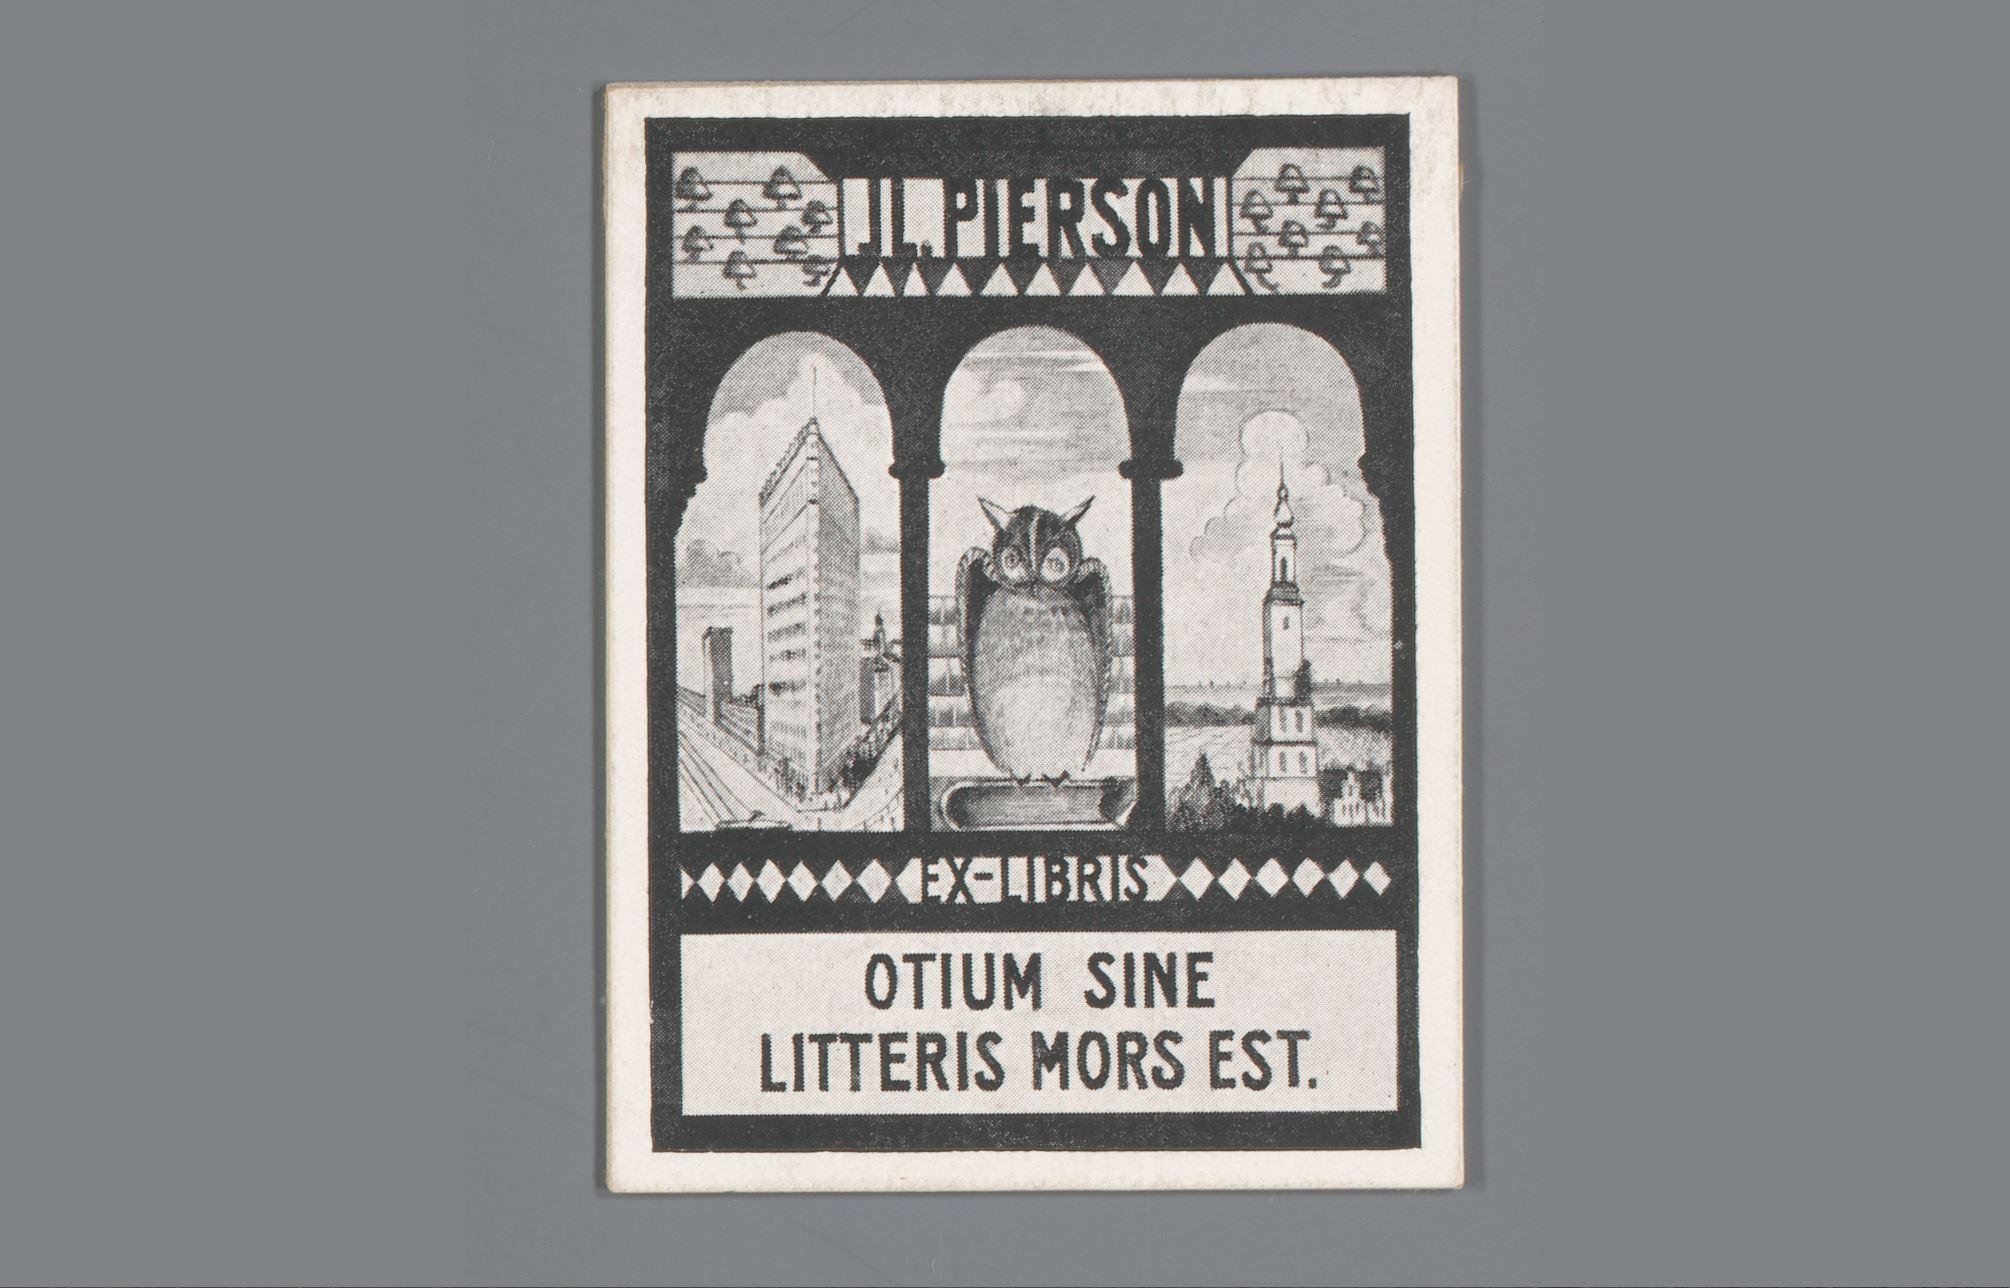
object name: photomechanical print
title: Otium sine litteris mors est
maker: Anonymous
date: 1921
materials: paper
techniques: autotype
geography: netherlands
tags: jan lodewijk pierson jr., parts of church exterior and annexes: campanile, colonnade, owls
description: Stapel van vijf identieke ex libris, aan een zijde aan elkaar bevestigd d.m.v. een lijmstrip zodat de ex librissen individueel kunnen worden afgescheurd.